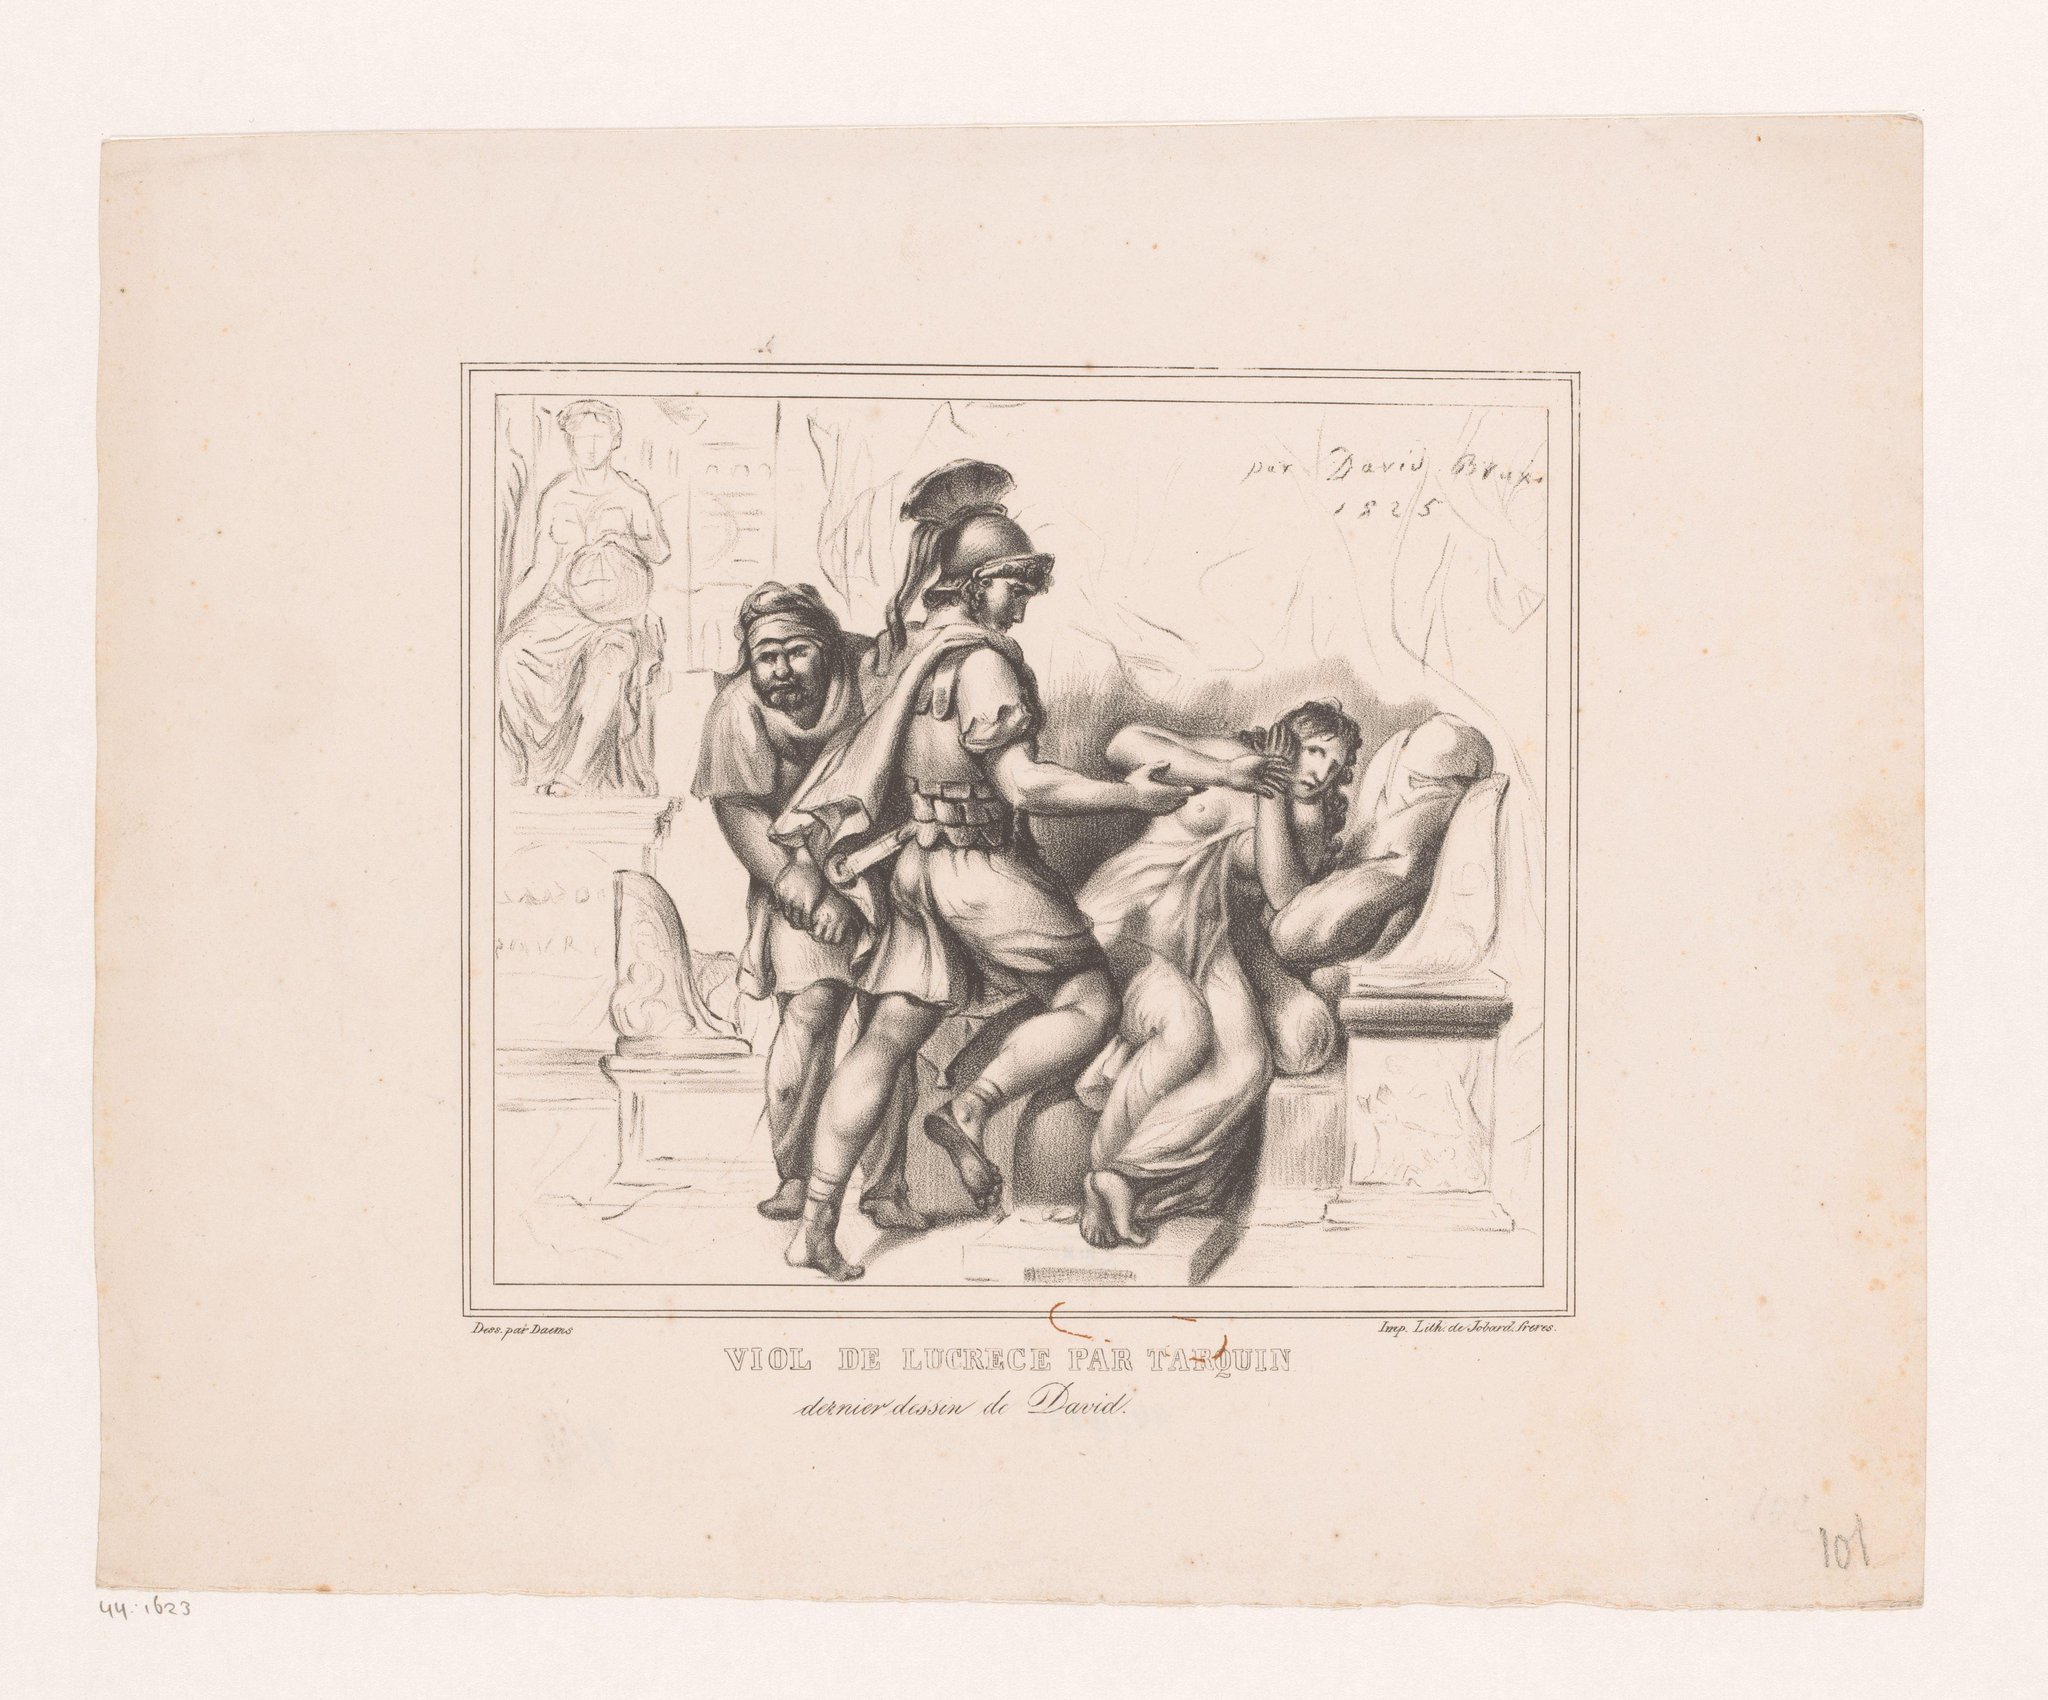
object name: print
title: Sextus Tarquinius en Lucretia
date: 1825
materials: paper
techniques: lithograph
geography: brussels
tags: suffering, misfortune of lucretia, bedroom, nude with covered genitals - aa - female human figure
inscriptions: collector's mark: Lugt 2228, check stamp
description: Sextus Tarquinius staat op het punt om Lucretia te verkrachten.